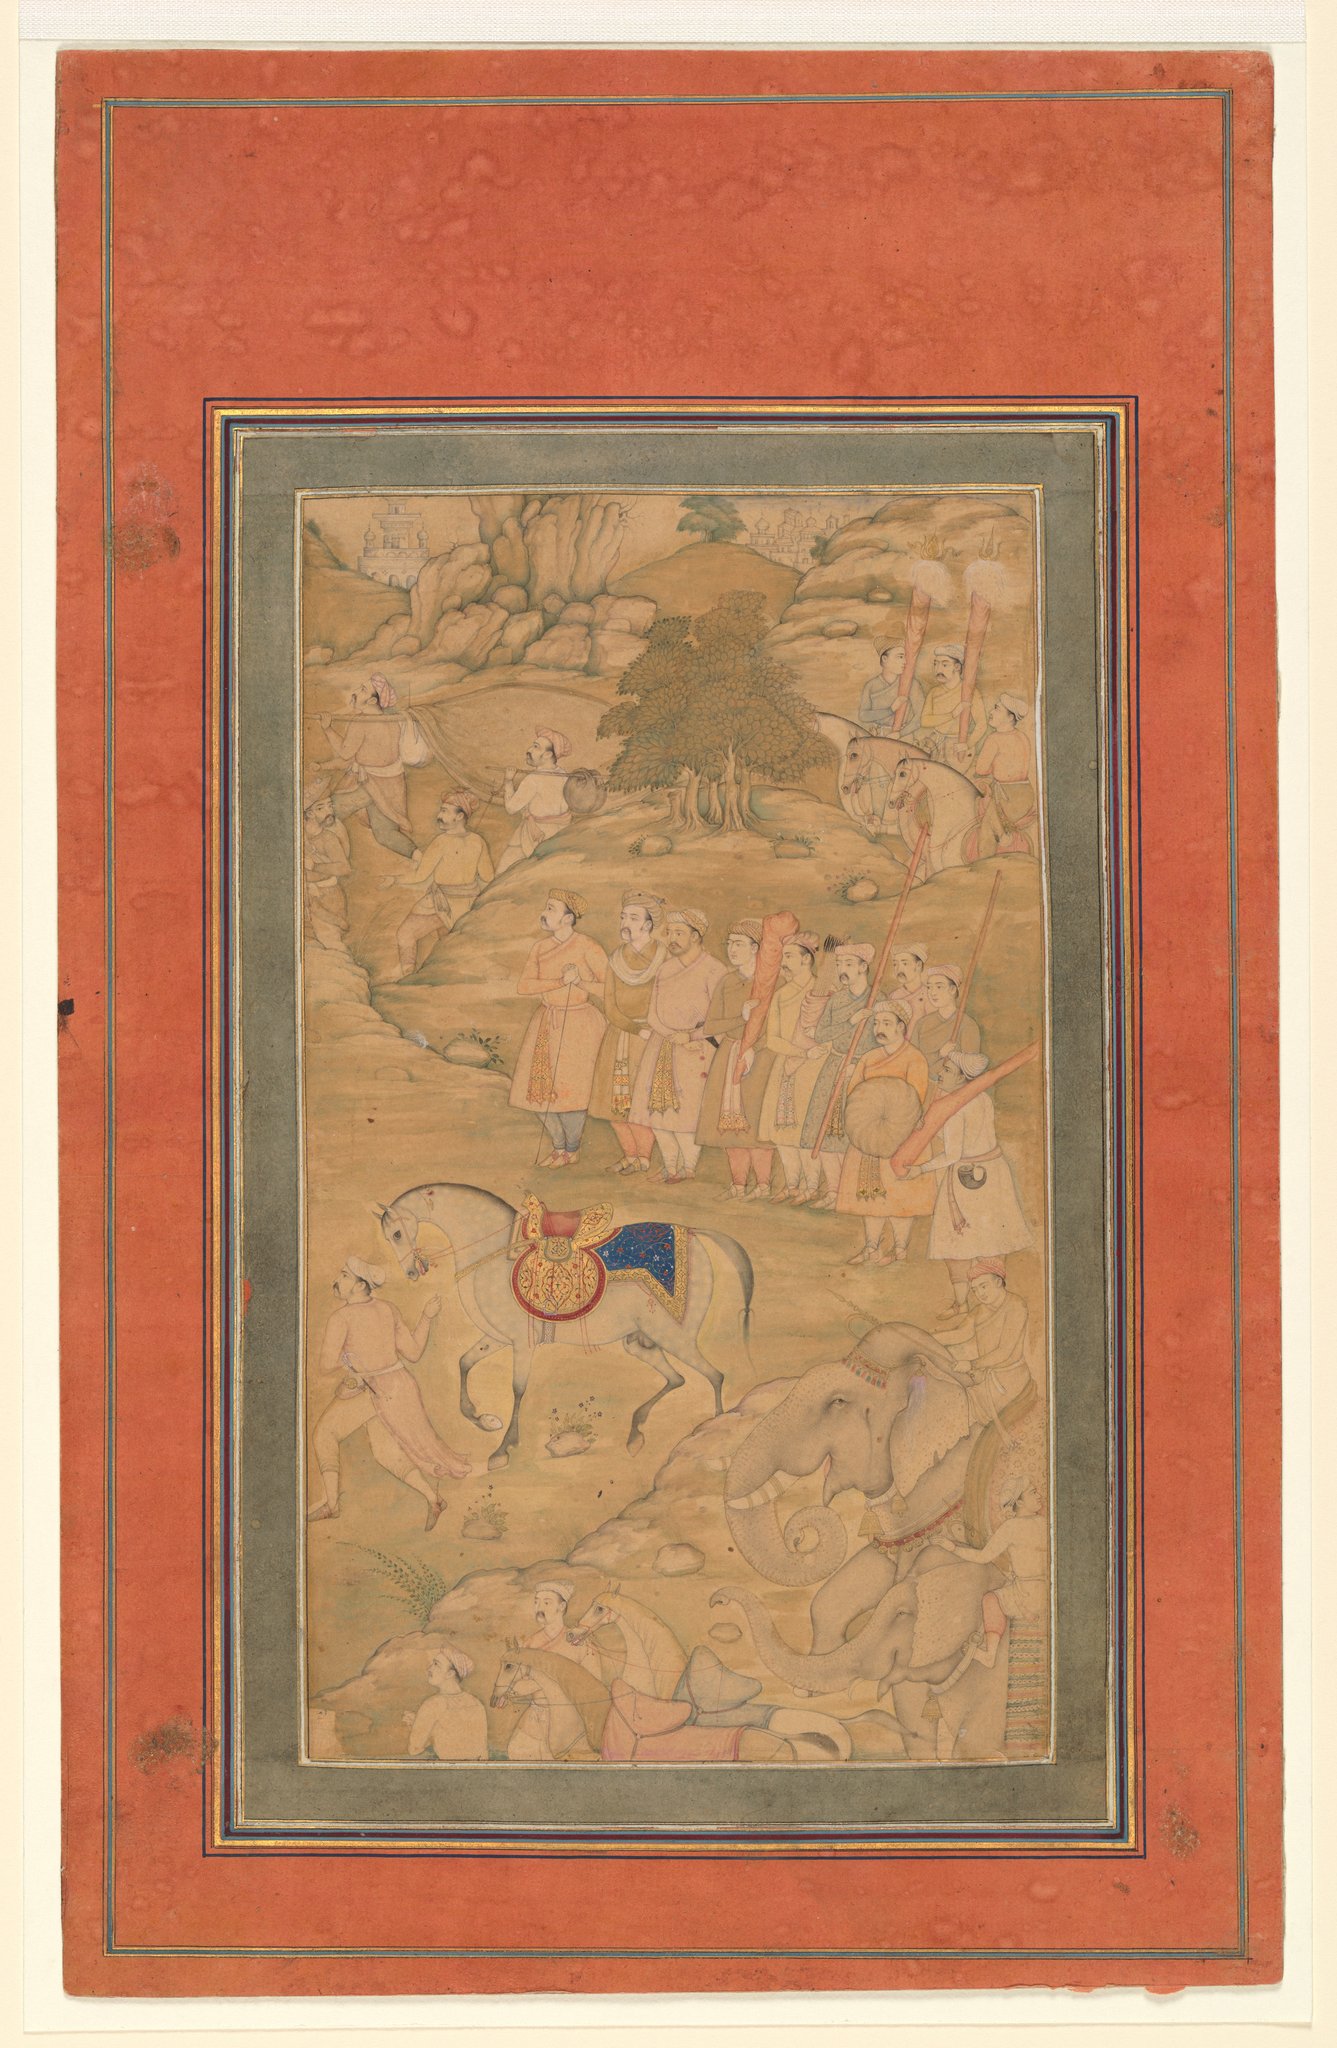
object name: illustrated album leaf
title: "Courtiers with a Riderless Horse", Folio from a Manuscript of the Akbarnama. Folio from the Davis Album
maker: abu'l fazl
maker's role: author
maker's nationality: indian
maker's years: 1556-1602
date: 1604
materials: gold, ink, paper, watercolor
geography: india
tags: men,elephants,horses